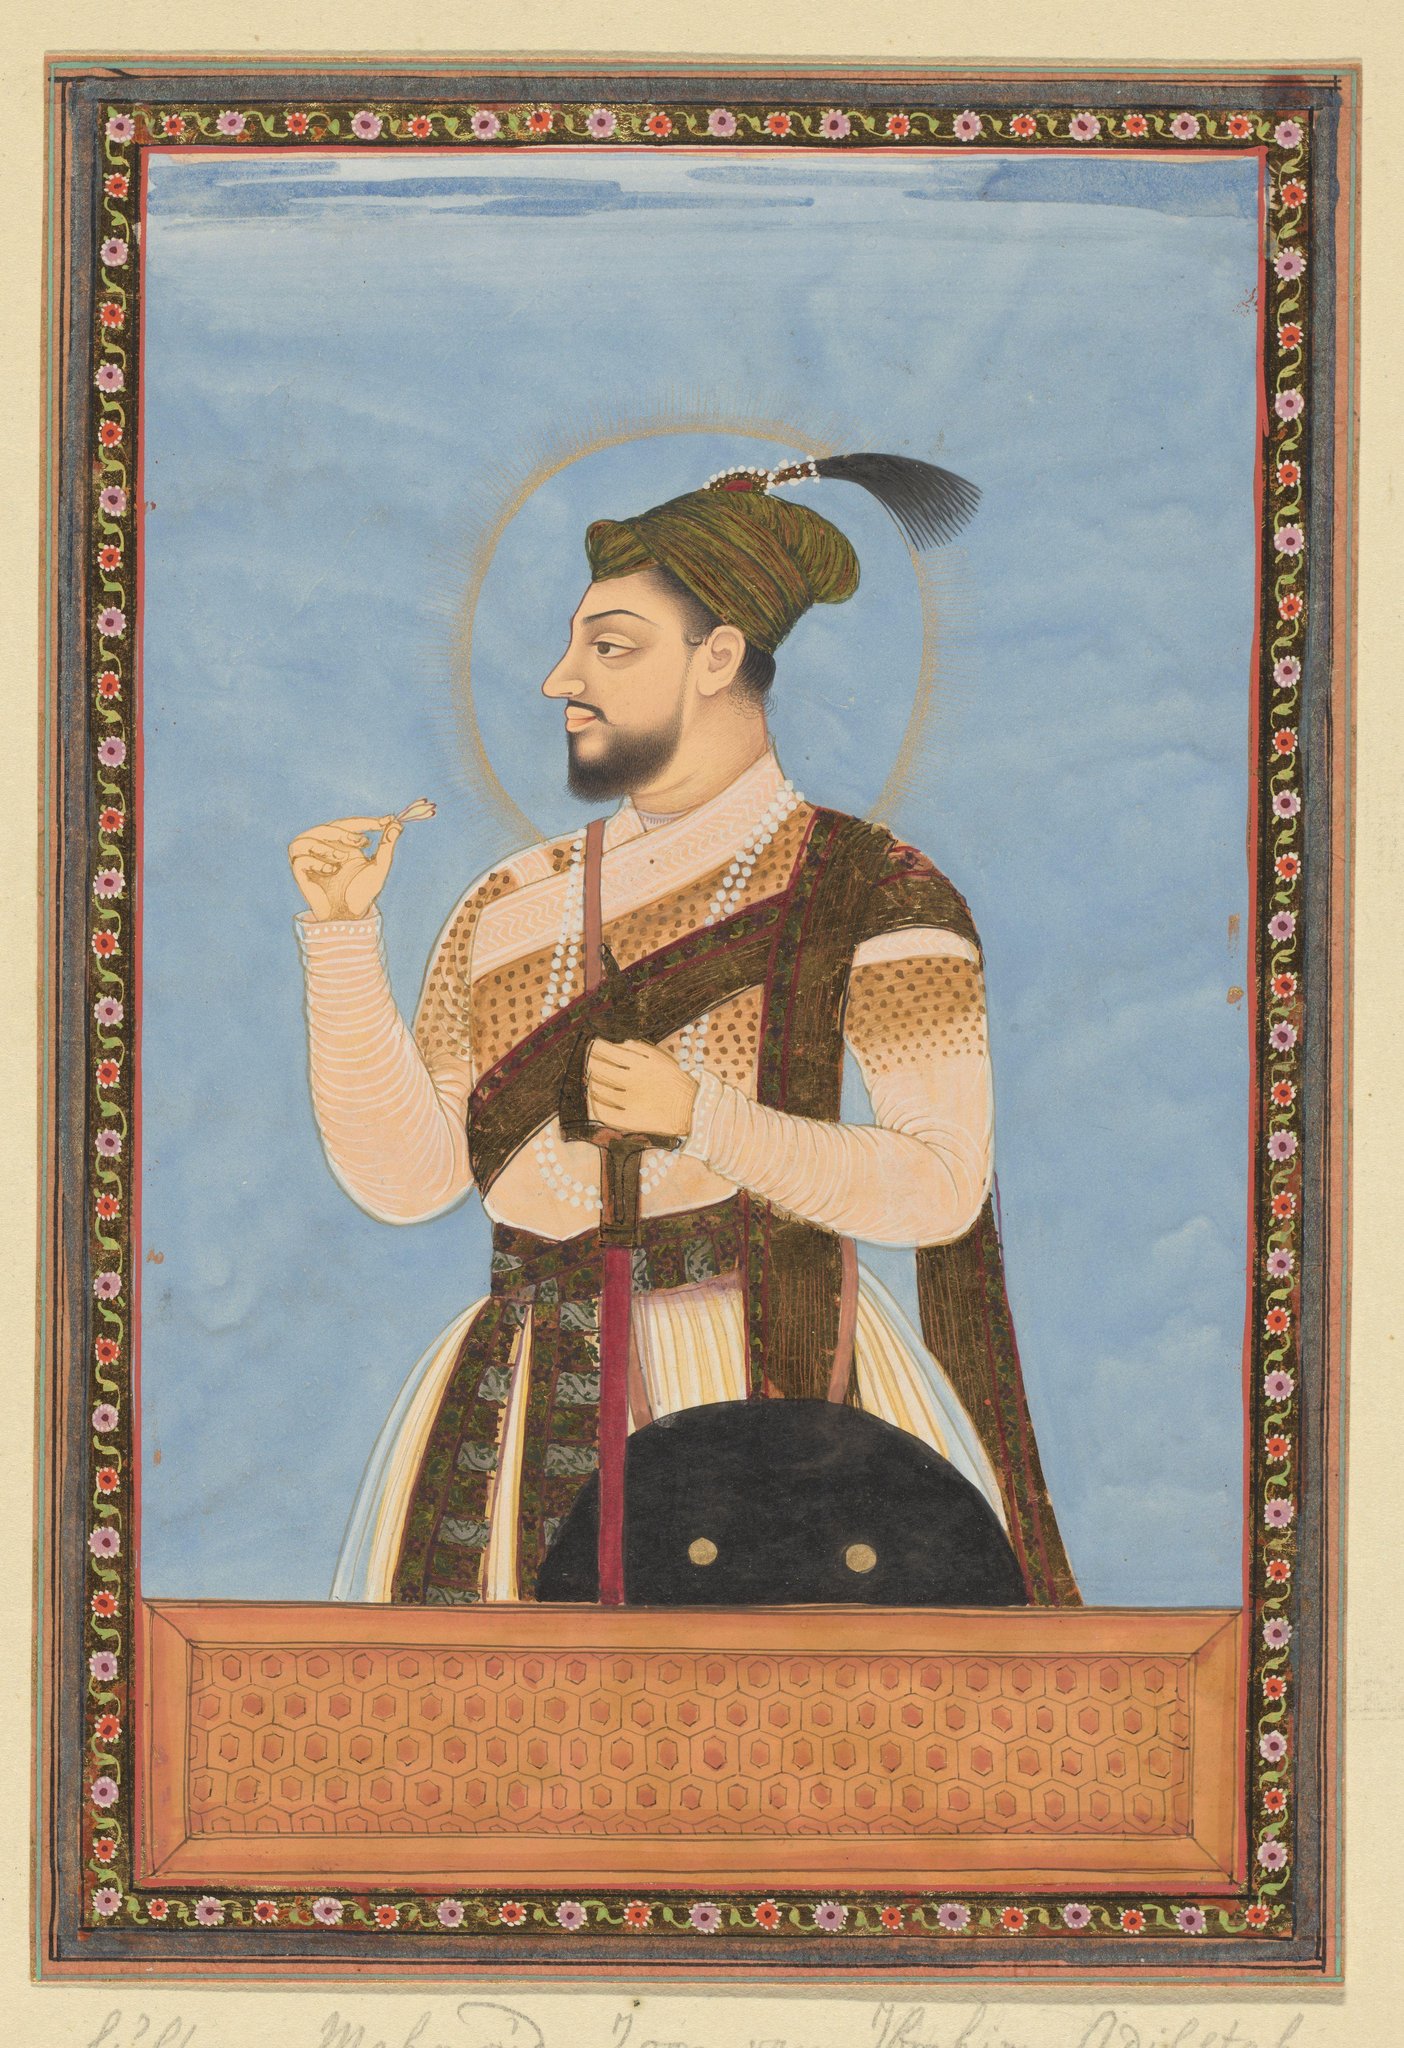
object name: indian miniature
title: Portret van Sultan Mahmud, zoon van Ibrahim Adil-shah; na zijn vader is hij heerser over Bijapur geweest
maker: Anonymous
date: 1686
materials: paint, gold leaf, gouache, paper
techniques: brush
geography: golkonda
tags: amsterdam, print maker, nicolaes cornelisz. witsen, historical person (...) - historical person (...) portrayed alone, ruler, sovereign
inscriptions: annotation: ‘Sultan Mahmoud, Zoon van Ibrahim Adilstah Koning van Vigiapour’, collector's mark: Lugt 1838, collector's mark: Lugt 240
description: Sultan Mahmud is tot aan zijn heupen afgebeeld, naar links gewend, met in zijn linker hand een zwaard, in zijn rechter hand een bloem en een schild aan zijn linker zijde. Blad 40 in het `Witsen-Album', met 49 Indiase miniaturen van vorsten. Boven het portret een stukje papier met de naam in het Perzisch. Onder het portret een stukje papier met de naam in het Portugees.